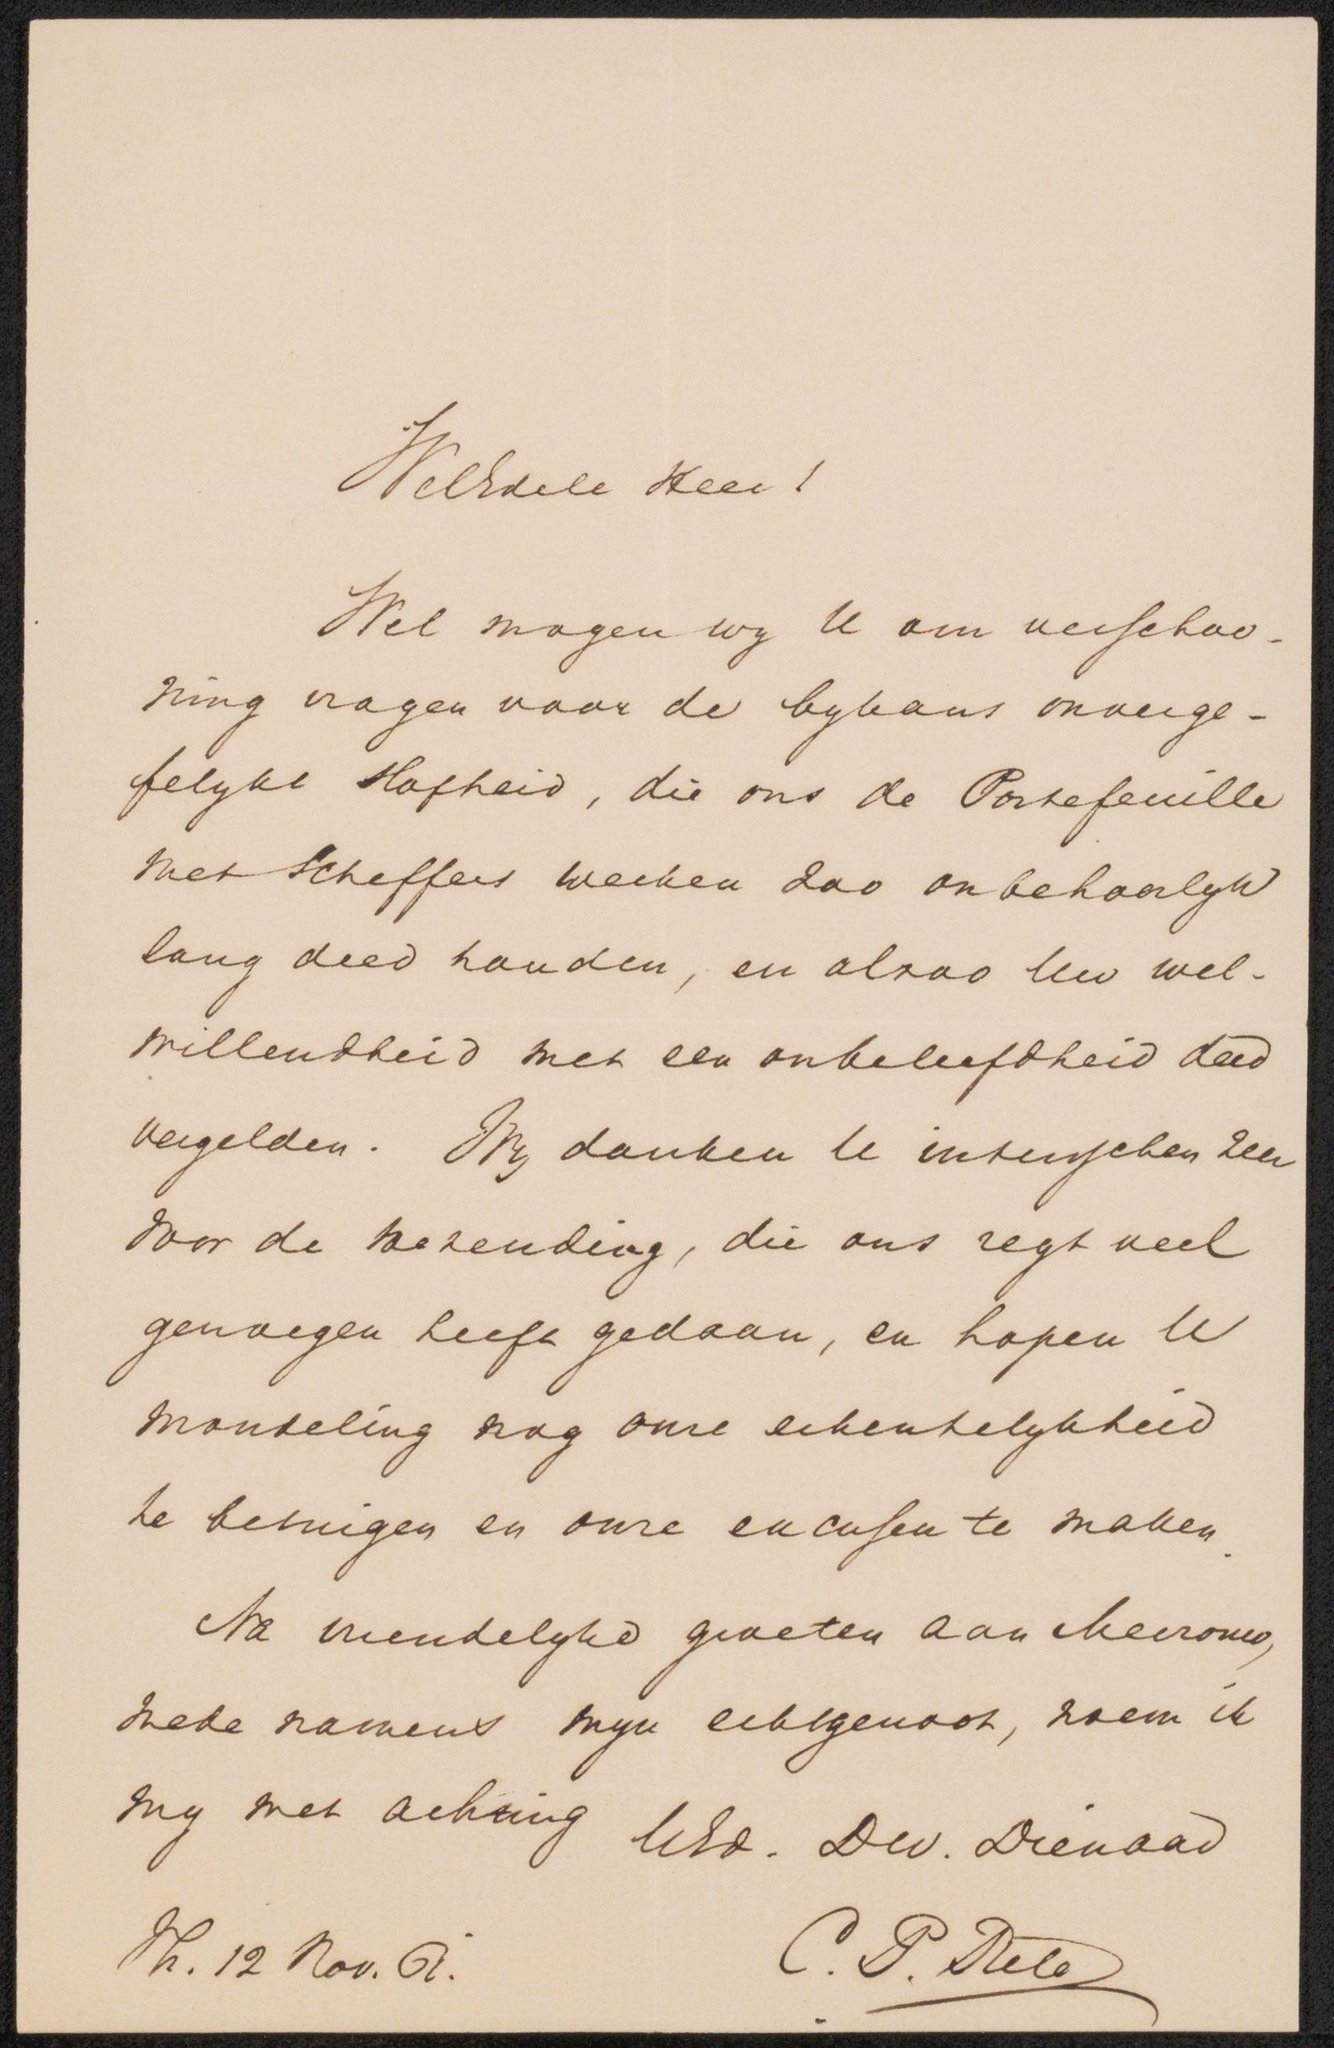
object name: letter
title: Brief aan Ary Johannes Lamme en Adriana Lamme-van Geller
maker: cornelis petrus tiele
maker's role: theoloog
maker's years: 1830-1902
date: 1861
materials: ink, paper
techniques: pen, writing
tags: rotterdam, painter, draughtsman, adriana lamme-van geller, dordrecht, print maker, sculptor, ary scheffer, ary johannes lamme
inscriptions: collector's mark: Lugt 2228